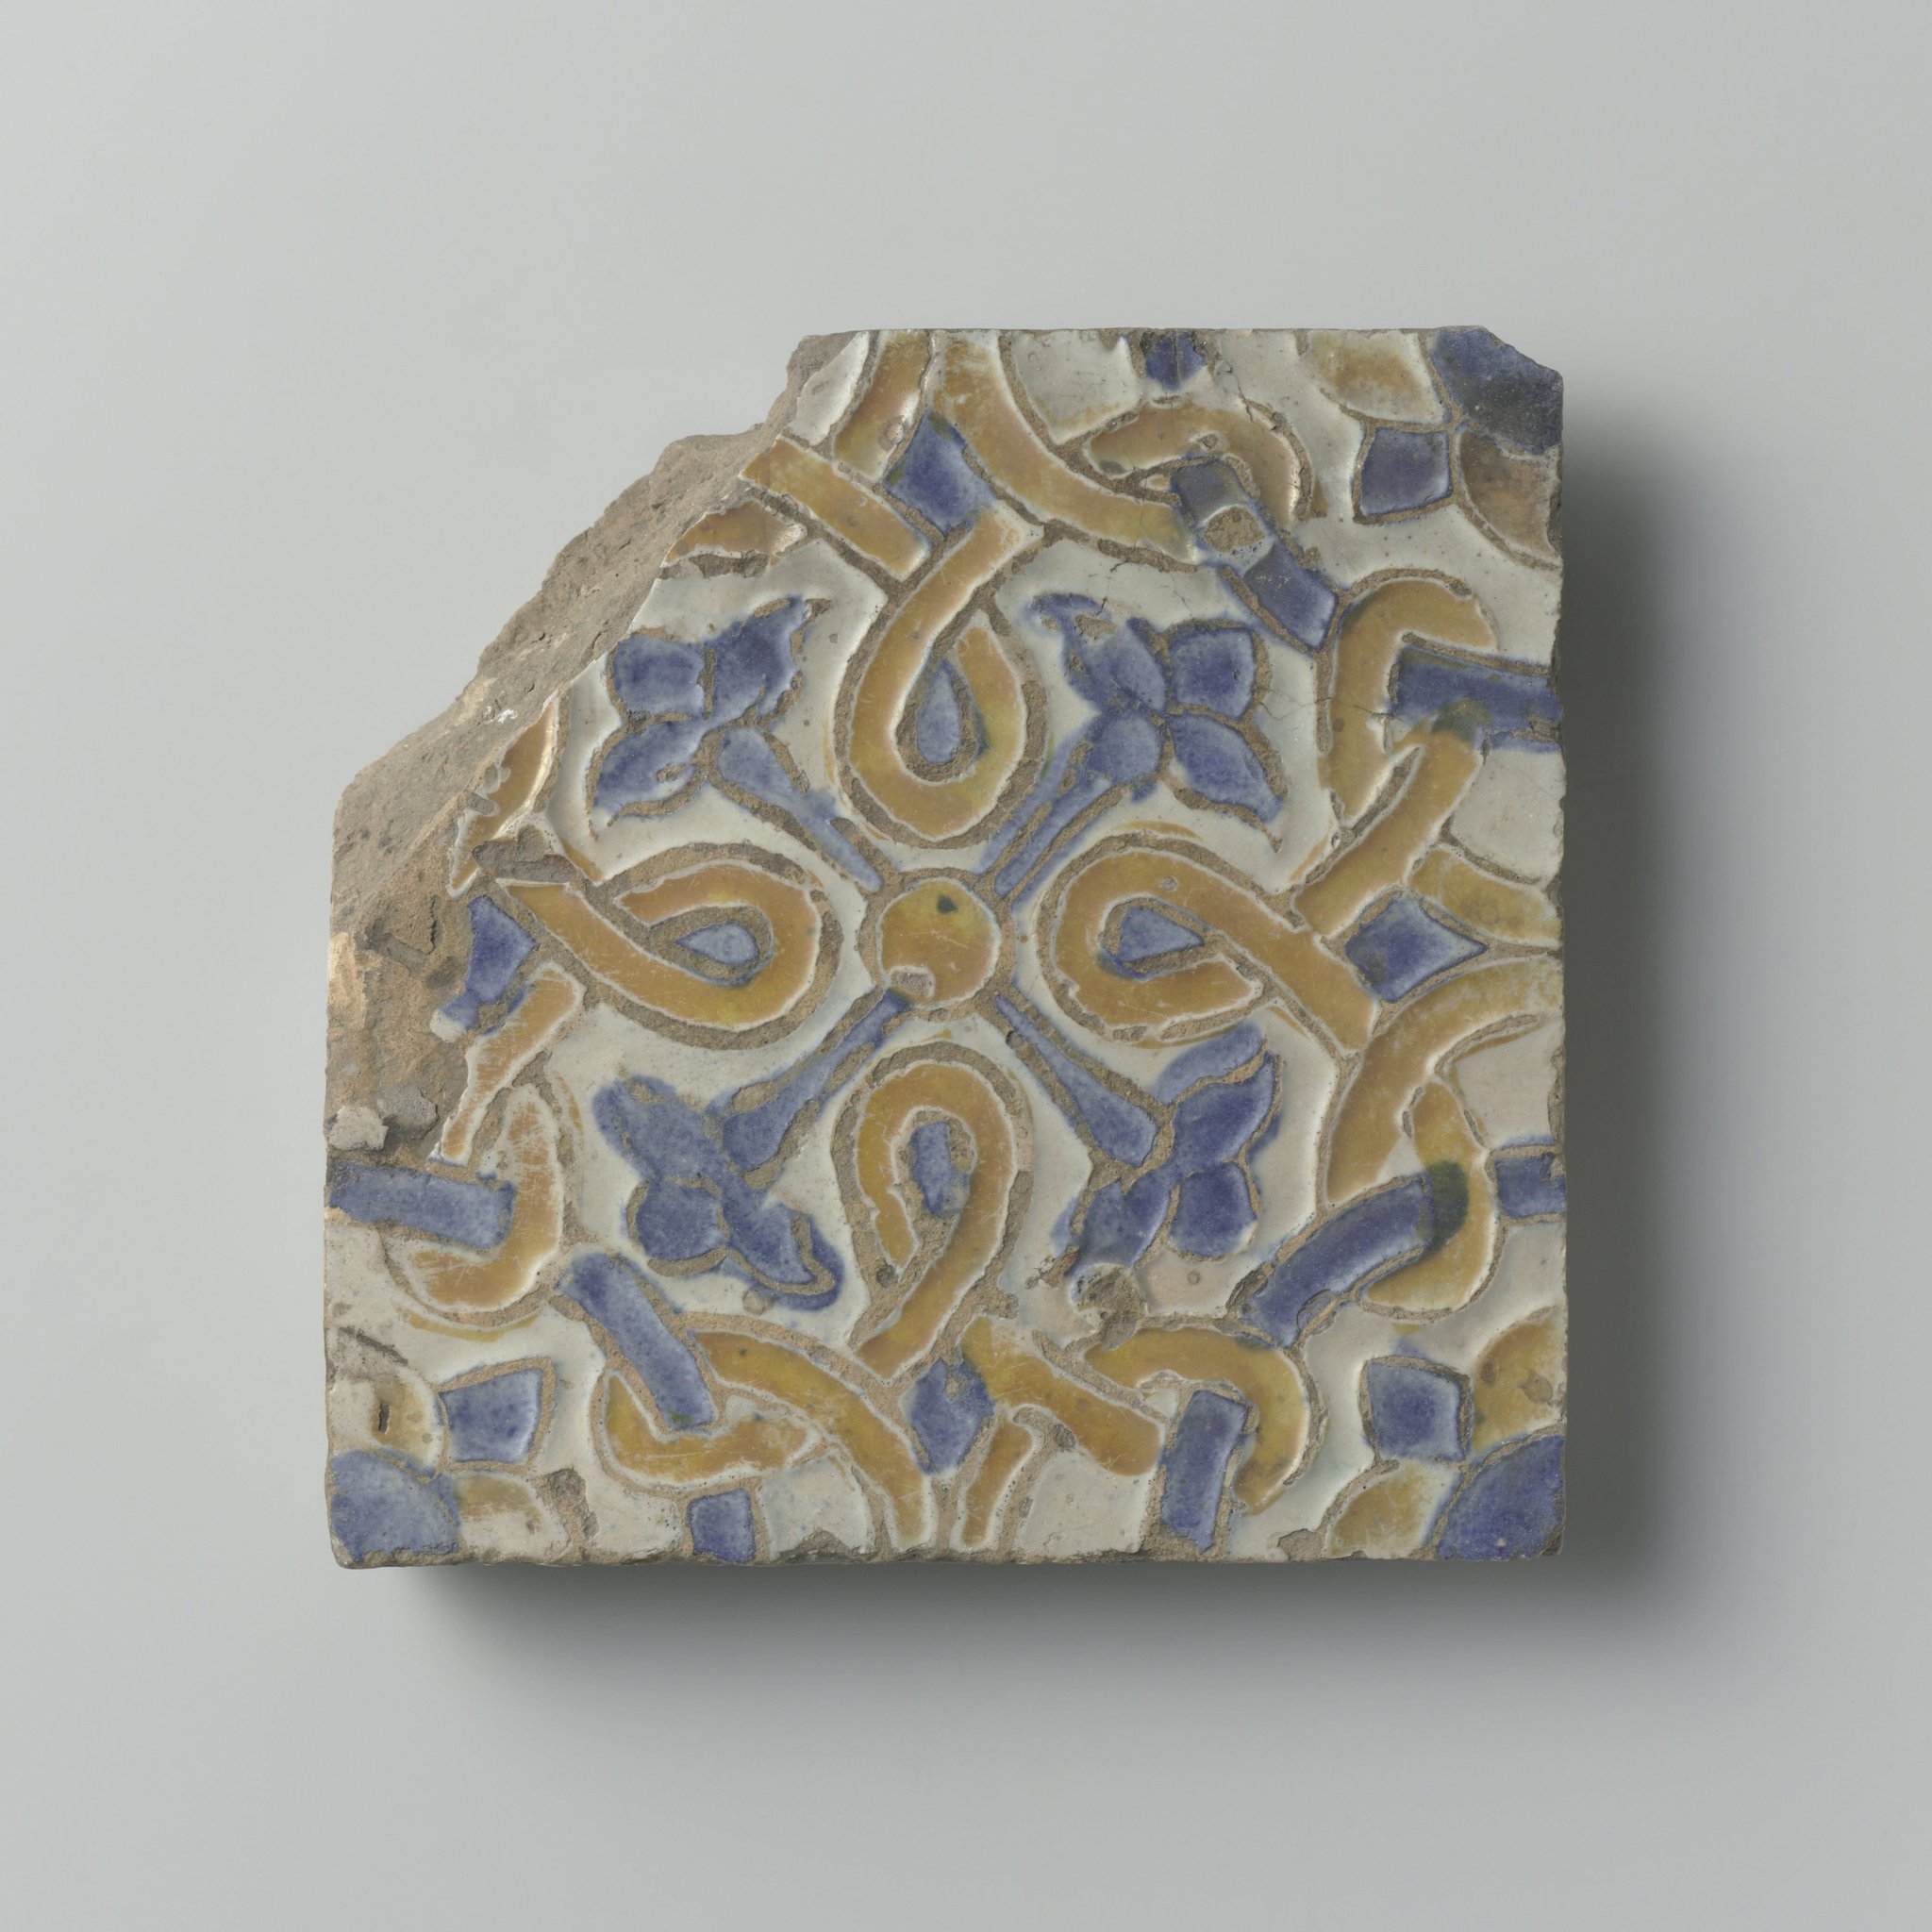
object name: tile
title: Tegel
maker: Anonymous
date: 1500-1600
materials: earthenware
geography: spain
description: Tegel, beschilderd in wit, blauw en geel/bruin, glazuur is verdiept en heeft een metaalglans. Decoratie van gevlochten banden waartussen bloemen.